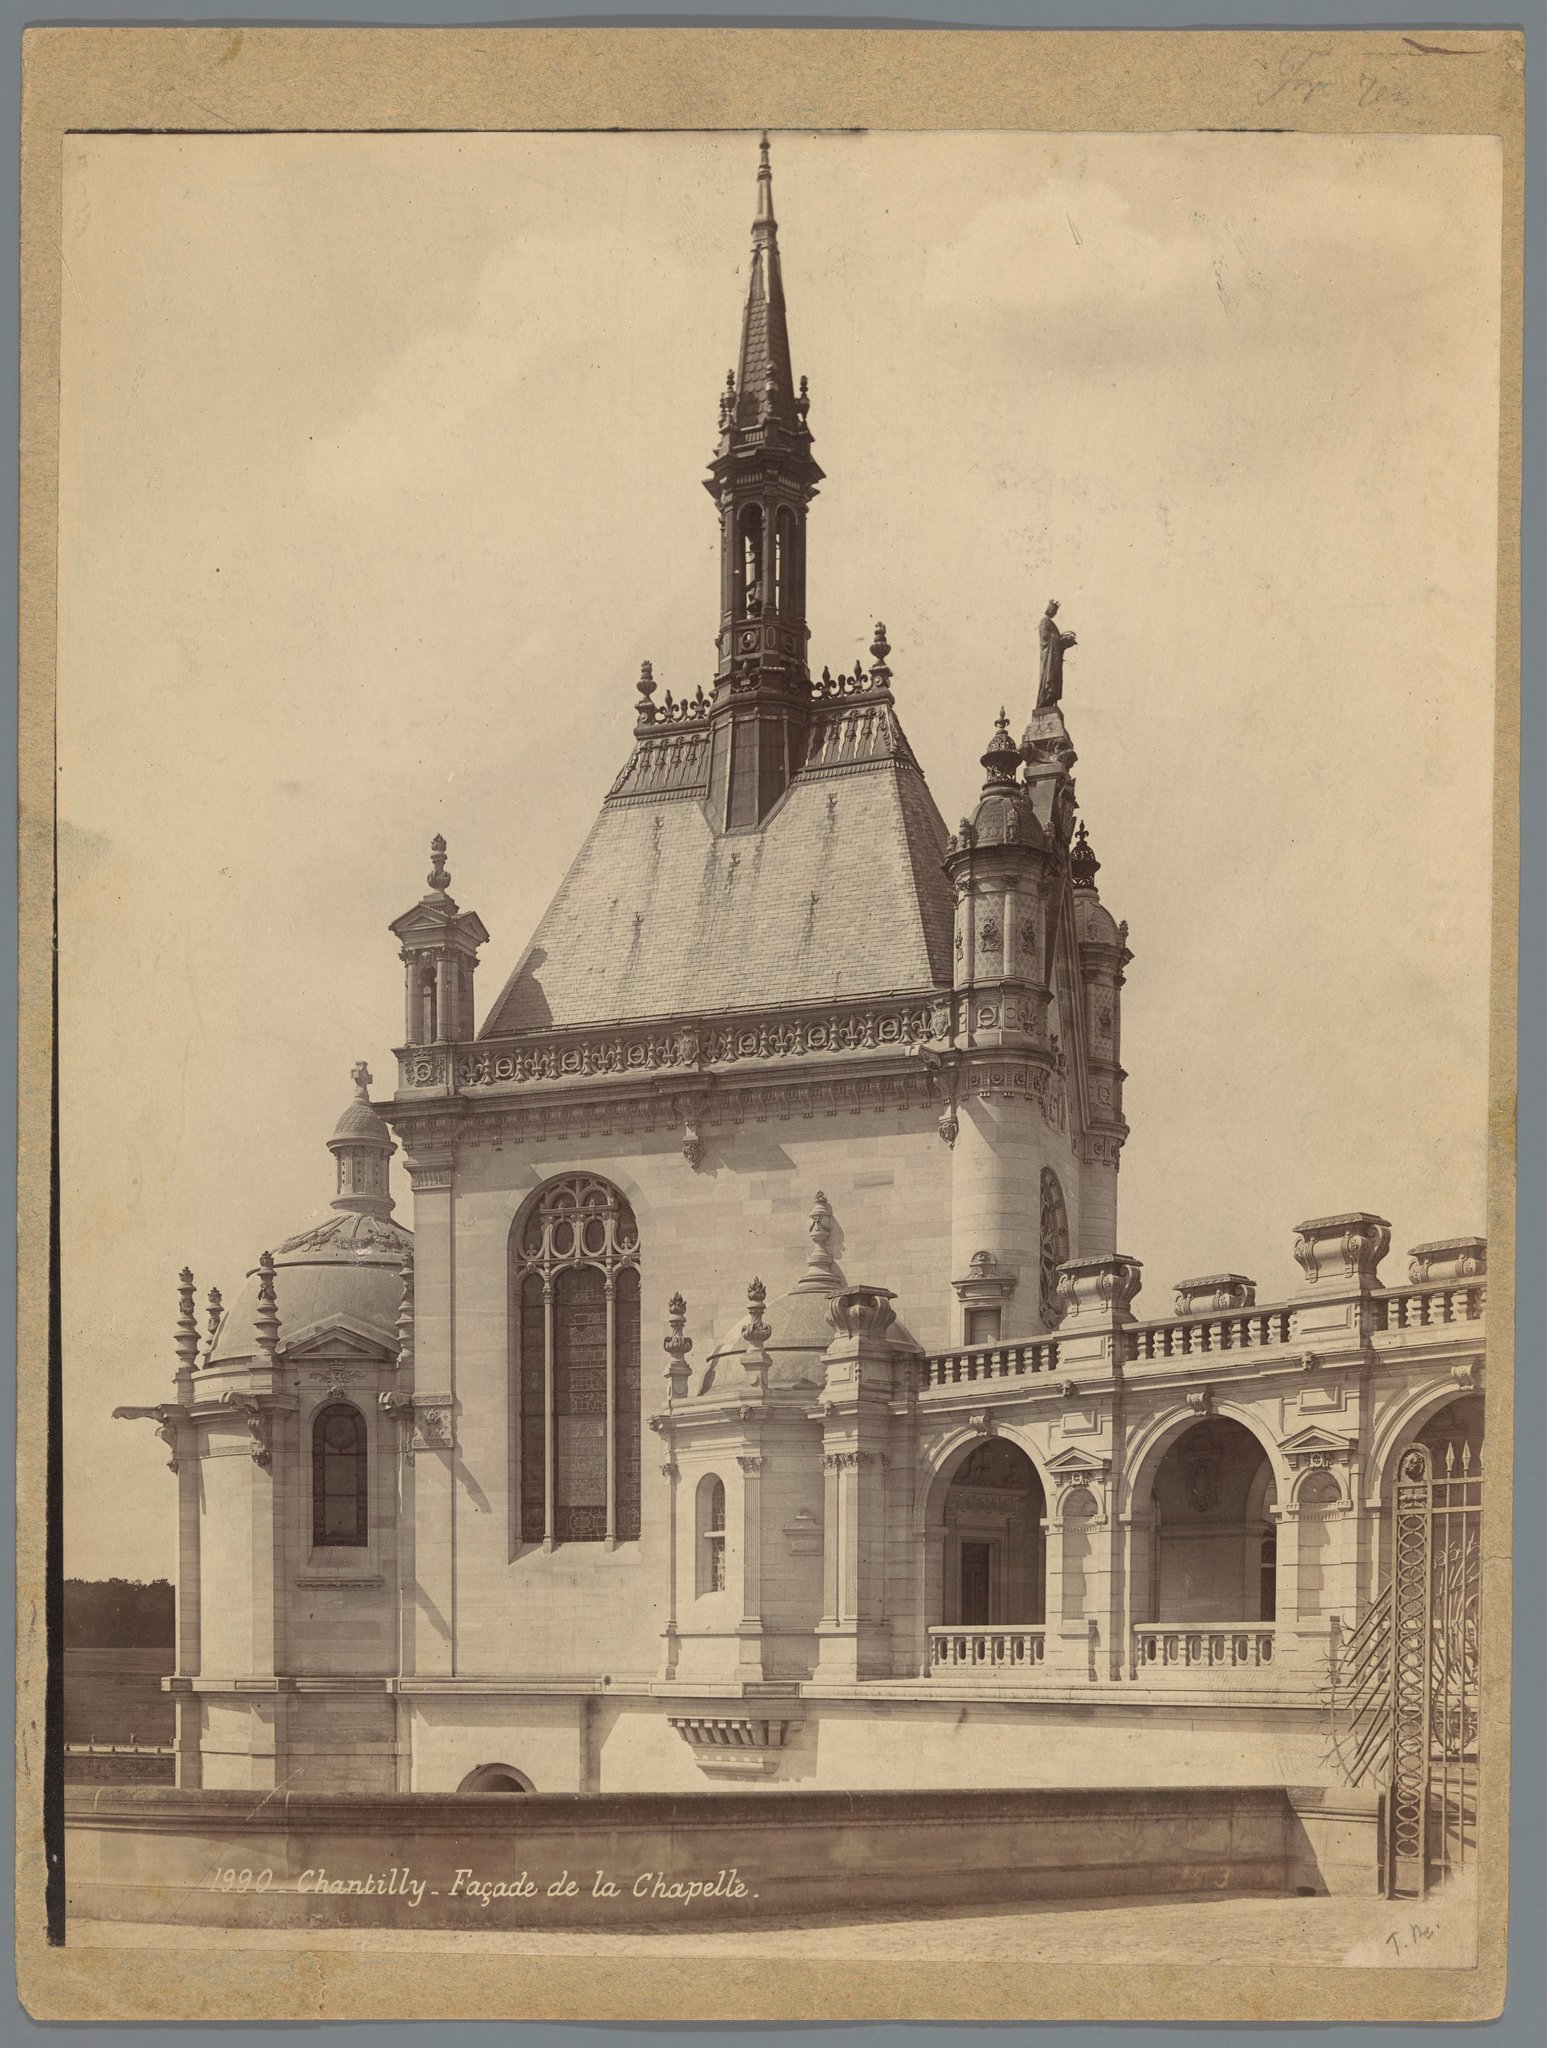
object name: photograph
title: Façade van de kapel van het Kasteel van Chantilly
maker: Anonymous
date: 1875-1900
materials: cardboard, photographic support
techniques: albumen print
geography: chantilly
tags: tower, clock tower ~ monumental adornment, church (exterior) - qq - small church, chapel, façade (of house or building), arcade ~ architecture, chantilly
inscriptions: collector's mark: Lugt 3937, inscription: ‘Top [...]’, number: ‘1990’